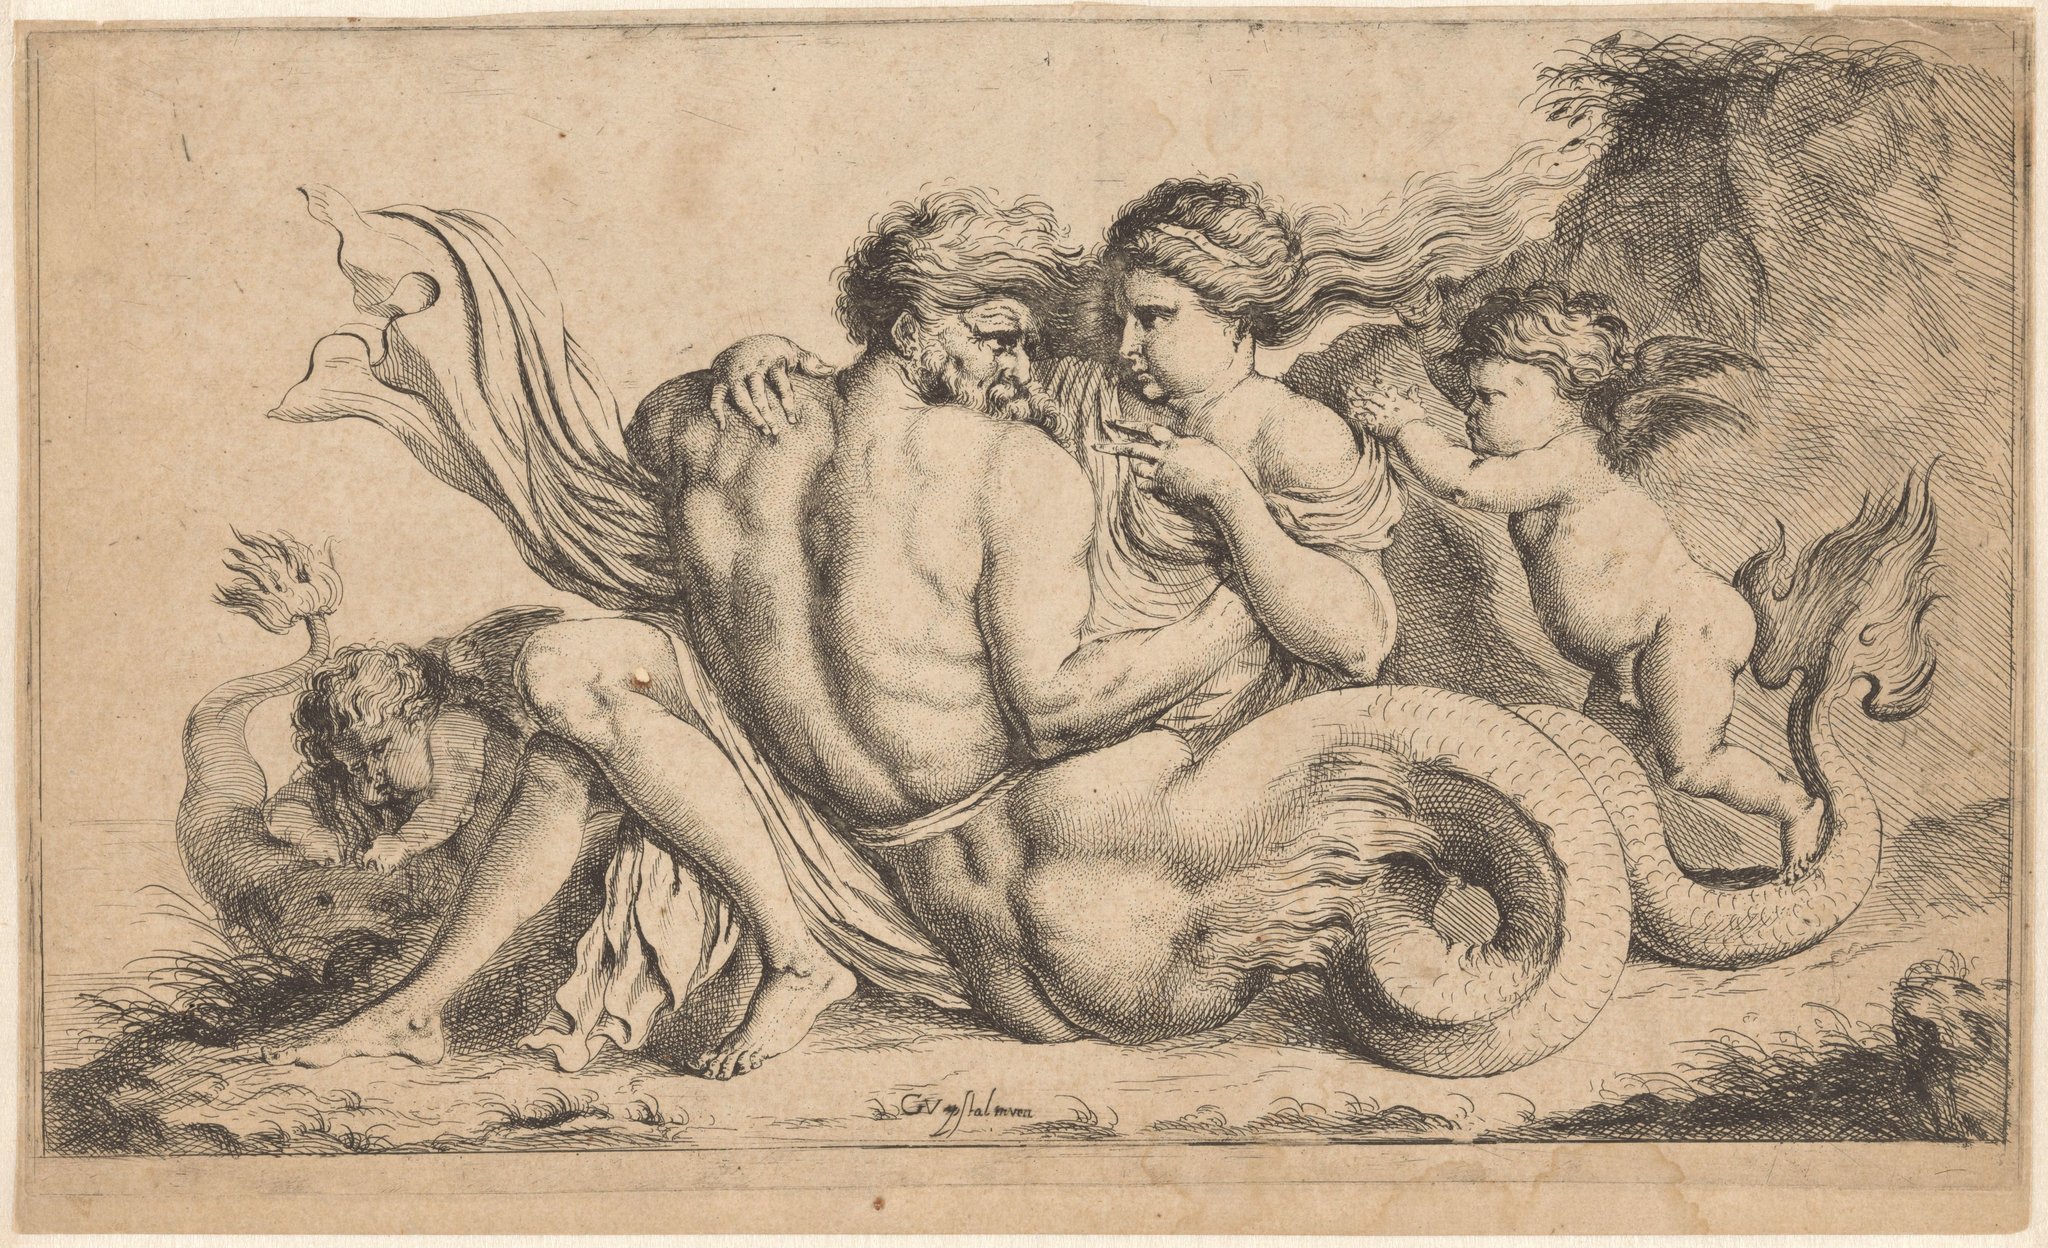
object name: print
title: Triton en nimf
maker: caspar jacob van opstal (ii)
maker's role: draughtsman, painter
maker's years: 1654-1717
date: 1670-1680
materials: paper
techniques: engraving, etching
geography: netherlands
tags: merman, nymphs (in general); 'ninfe in commune' (ripa), (story of) triton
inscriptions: collector's mark: Lugt 2228, collector's mark: Lugt 2760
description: Triton en een nimf in omhelzing, met daarnaast twee putti .